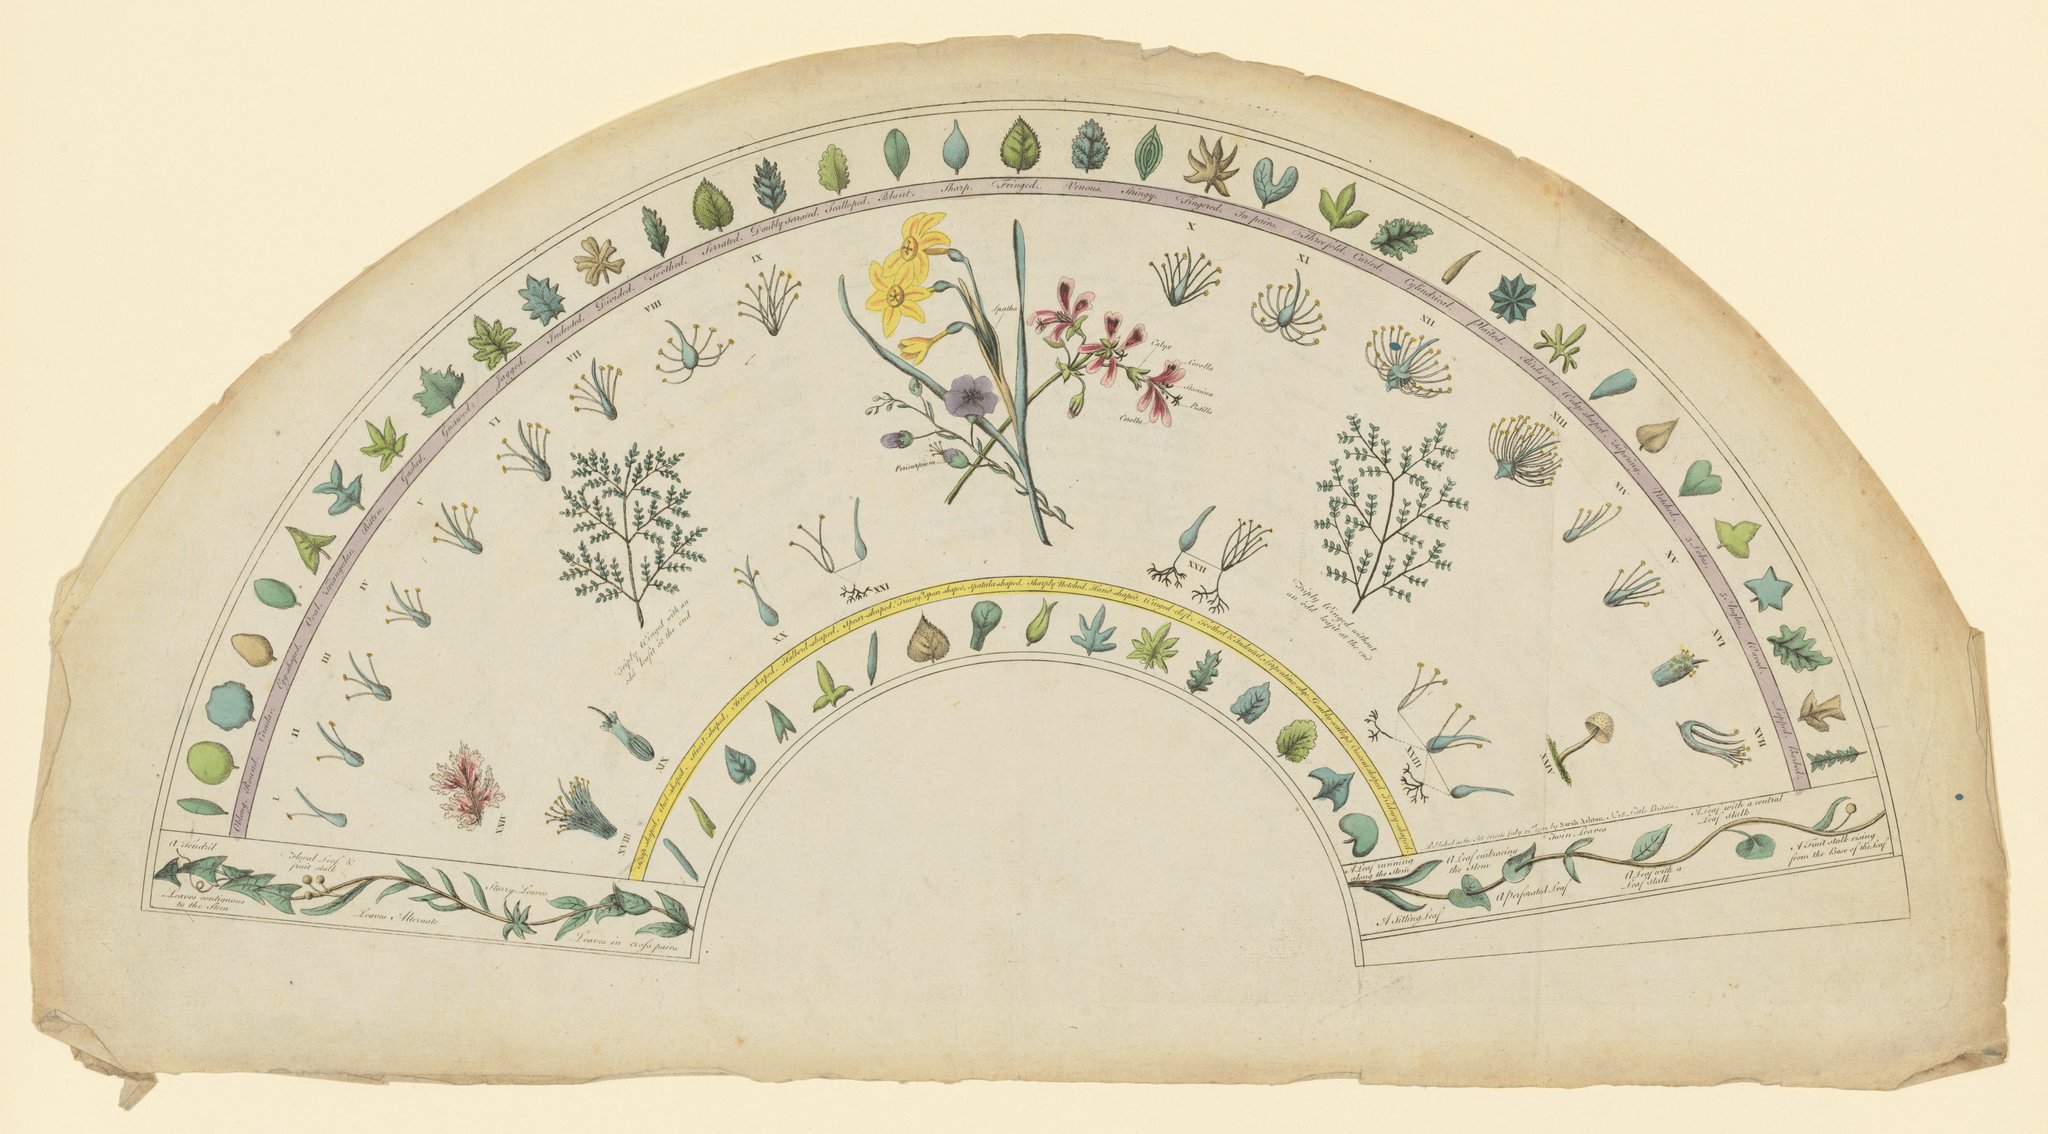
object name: print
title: Fan leaf adorned with botanical designs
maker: sarah ashton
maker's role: publisher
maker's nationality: british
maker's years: 1770-1798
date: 1792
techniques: etching, hand coloring